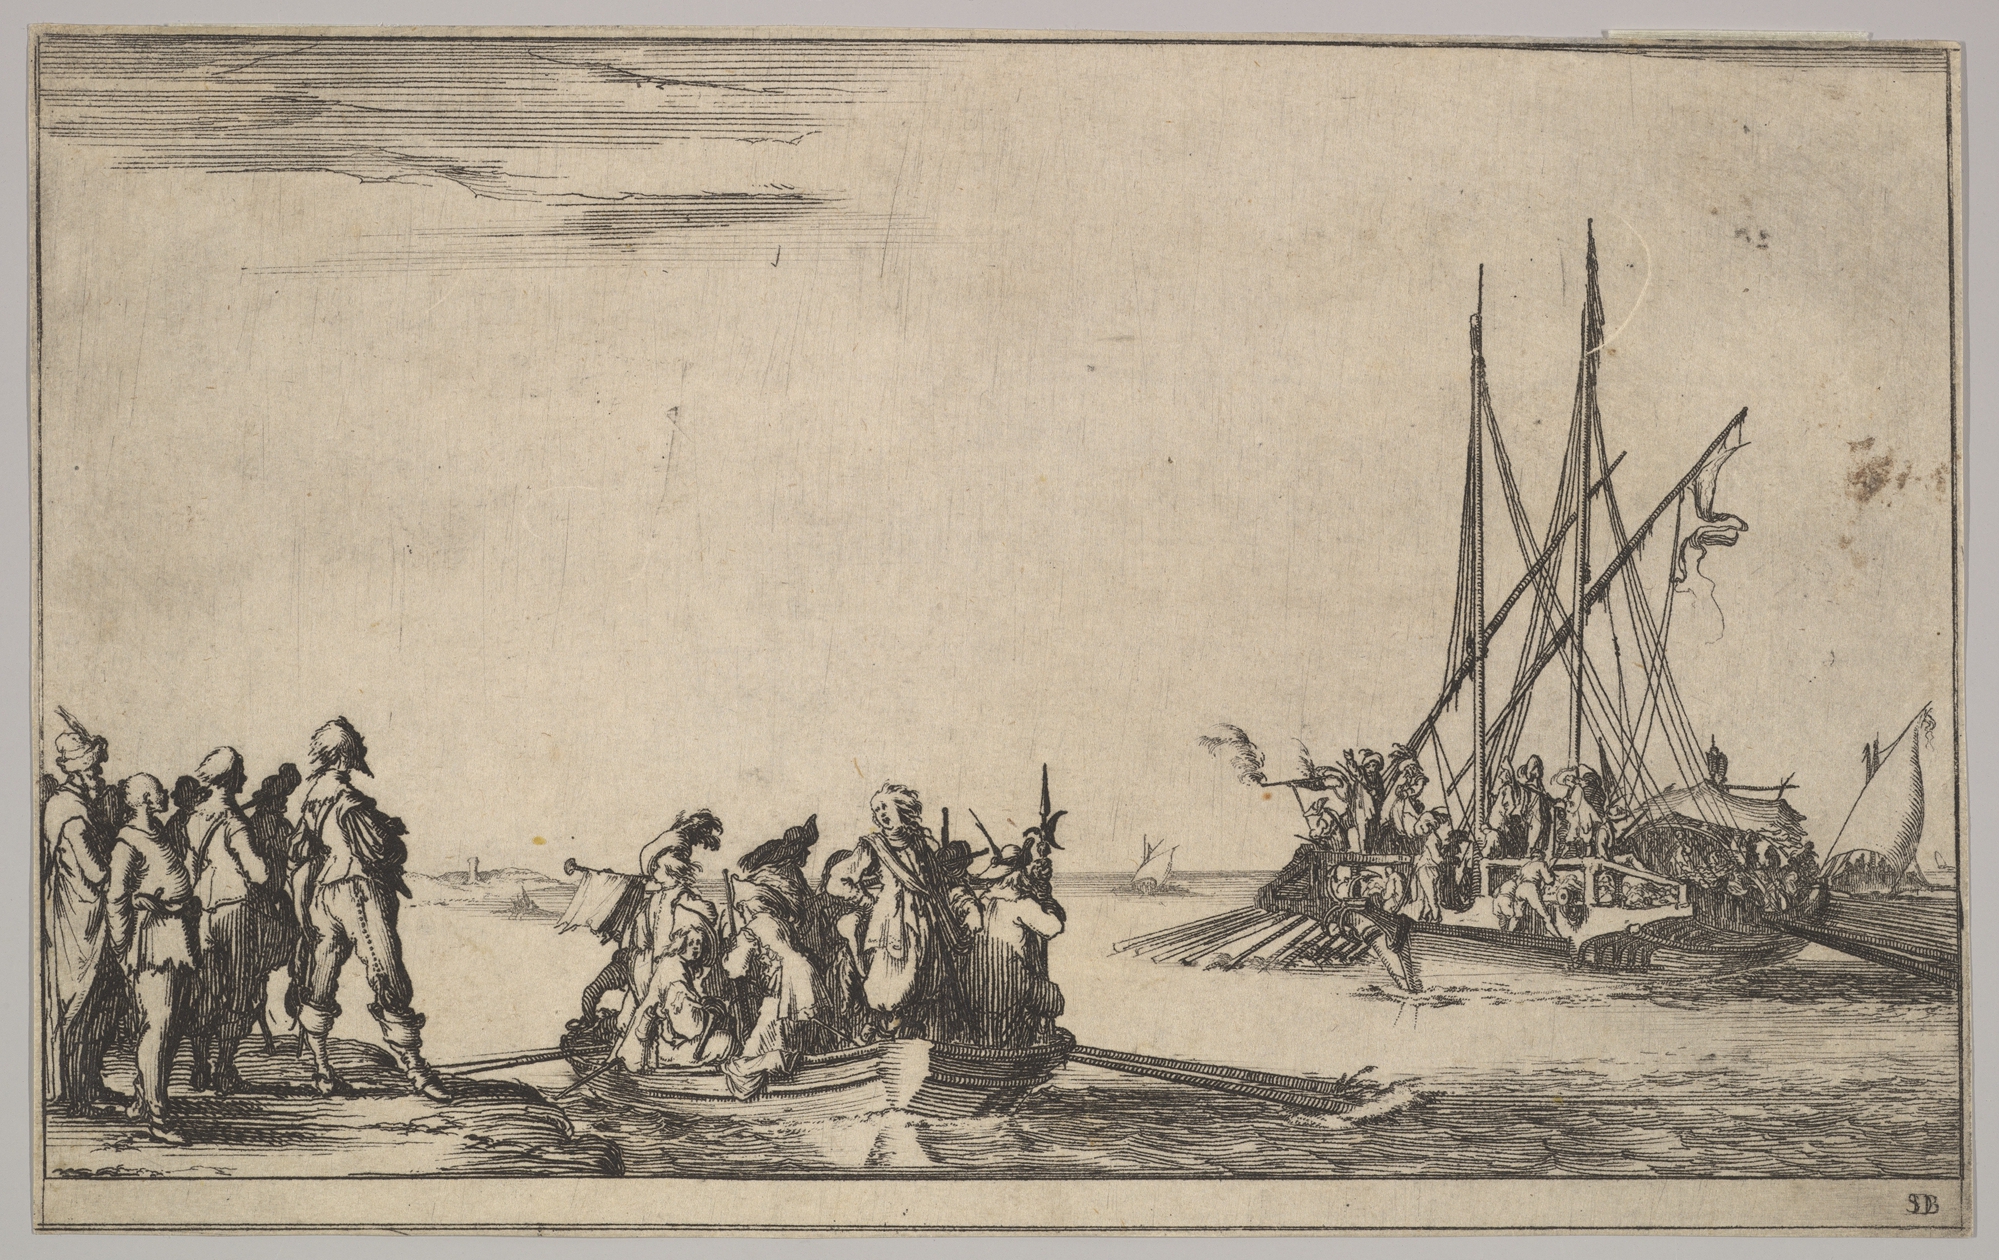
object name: print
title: A rowboat full of men in center, a group of men standing on shore at left, a ship full of men, one firing a pistol, at right, from "Set of eight nautical landscapes" (Suite de huit Marines)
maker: stefano della bella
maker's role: artist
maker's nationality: italian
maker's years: 1610-1664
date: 1639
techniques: etching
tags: men,boats